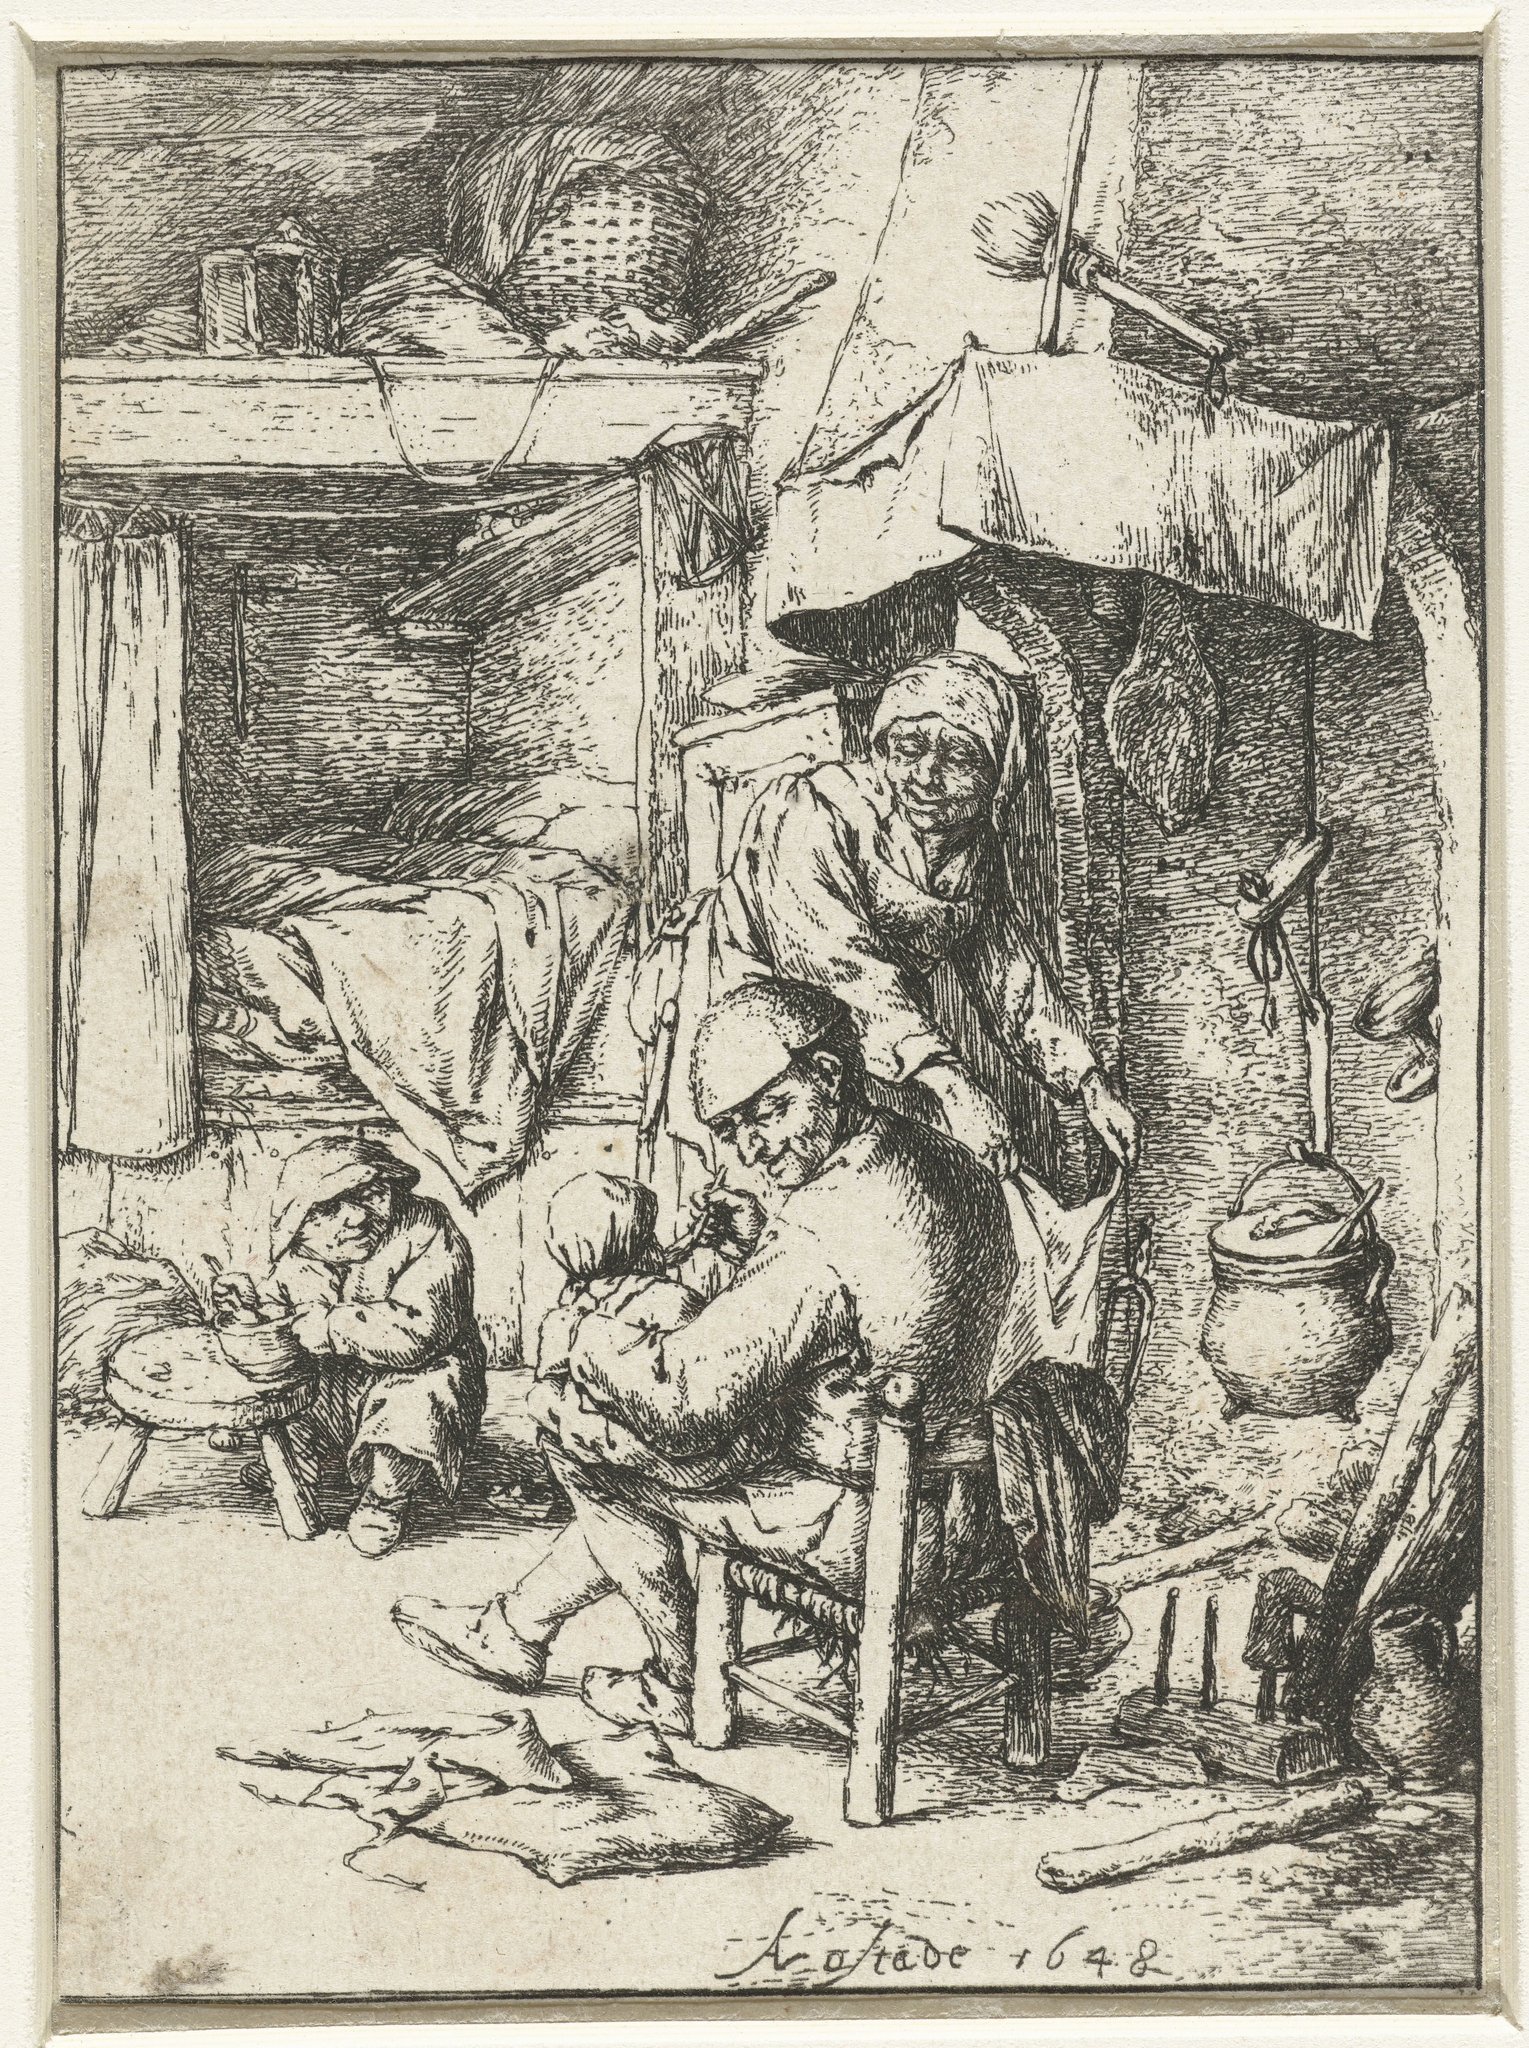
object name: print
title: De huisvader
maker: adriaen van ostade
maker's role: draughtsman, painter, print maker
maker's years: 1610-1685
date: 1648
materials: paper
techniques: etching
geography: haarlem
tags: (family) meal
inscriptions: collector's mark: Lugt 240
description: Een vader geeft een klein kind op zijn schoot te eten, de moeder staat bij de haard waar een pot boven het vuur hangt. Een klein kind zit op de grond bij een kruk te eten. Dit boeren gezin is gesitueerd in een armoedig interieur met verschillende huishoudelijke attributen en op de achtergrond een bedstee.